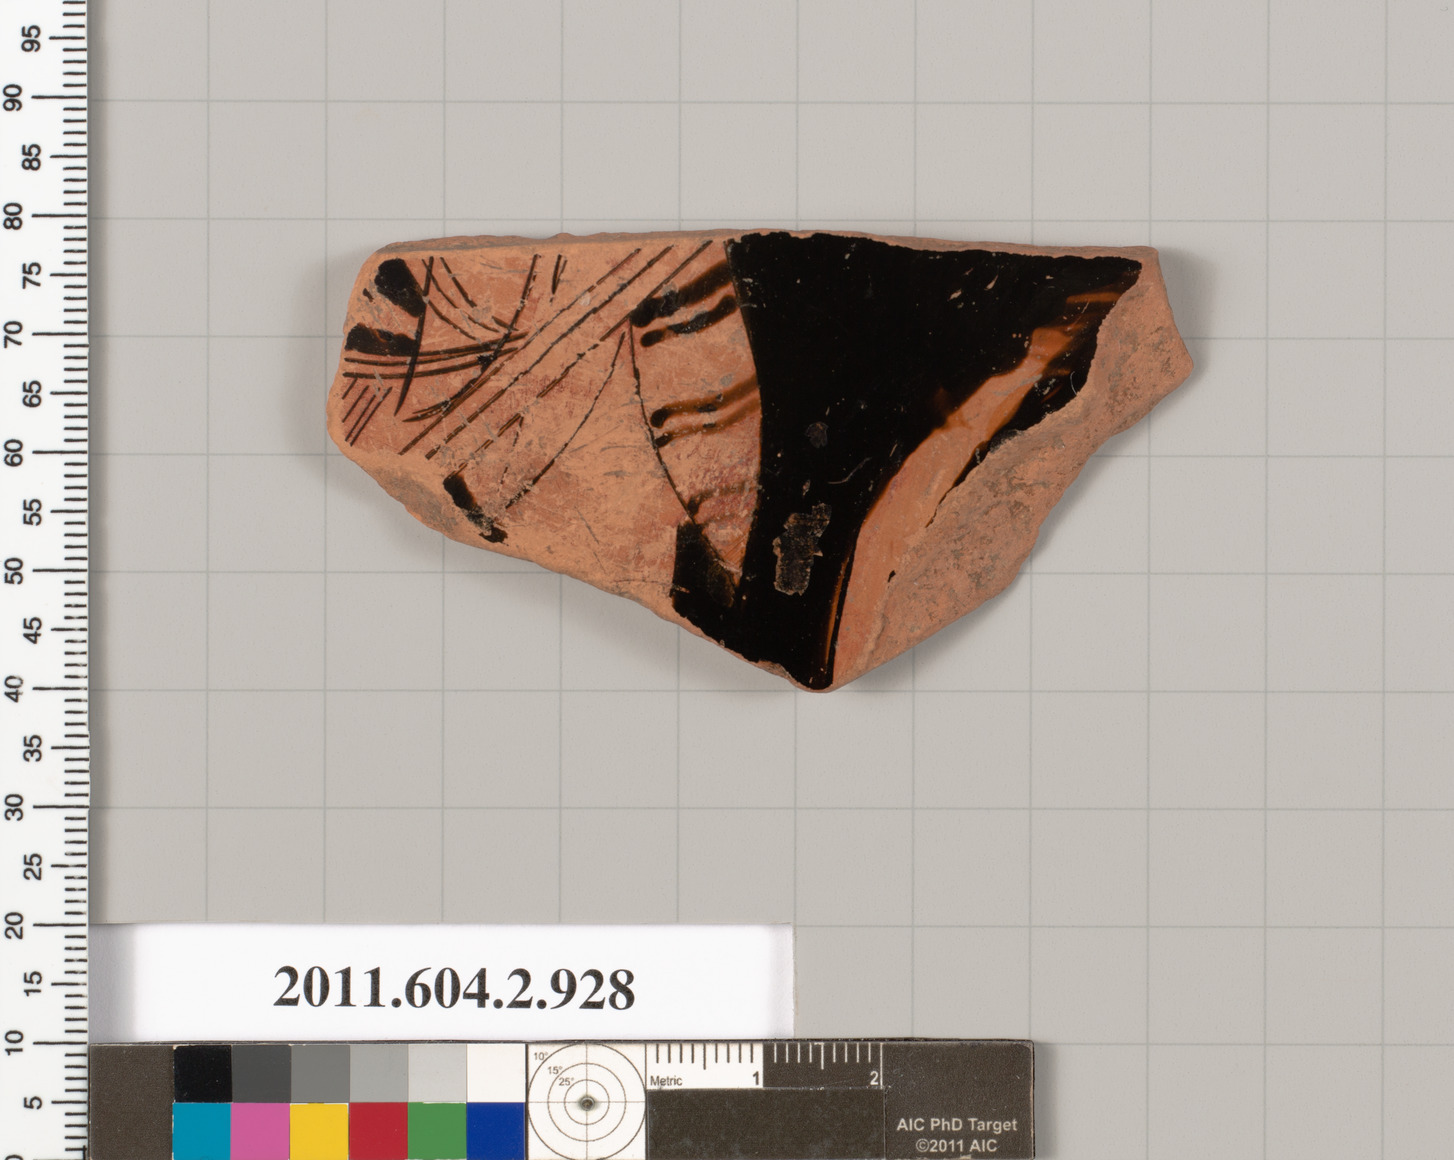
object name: kalpis fragment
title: Terracotta fragment of a hydria: kalpis (water jar)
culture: greek, attic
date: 460-450 BCE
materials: terracotta